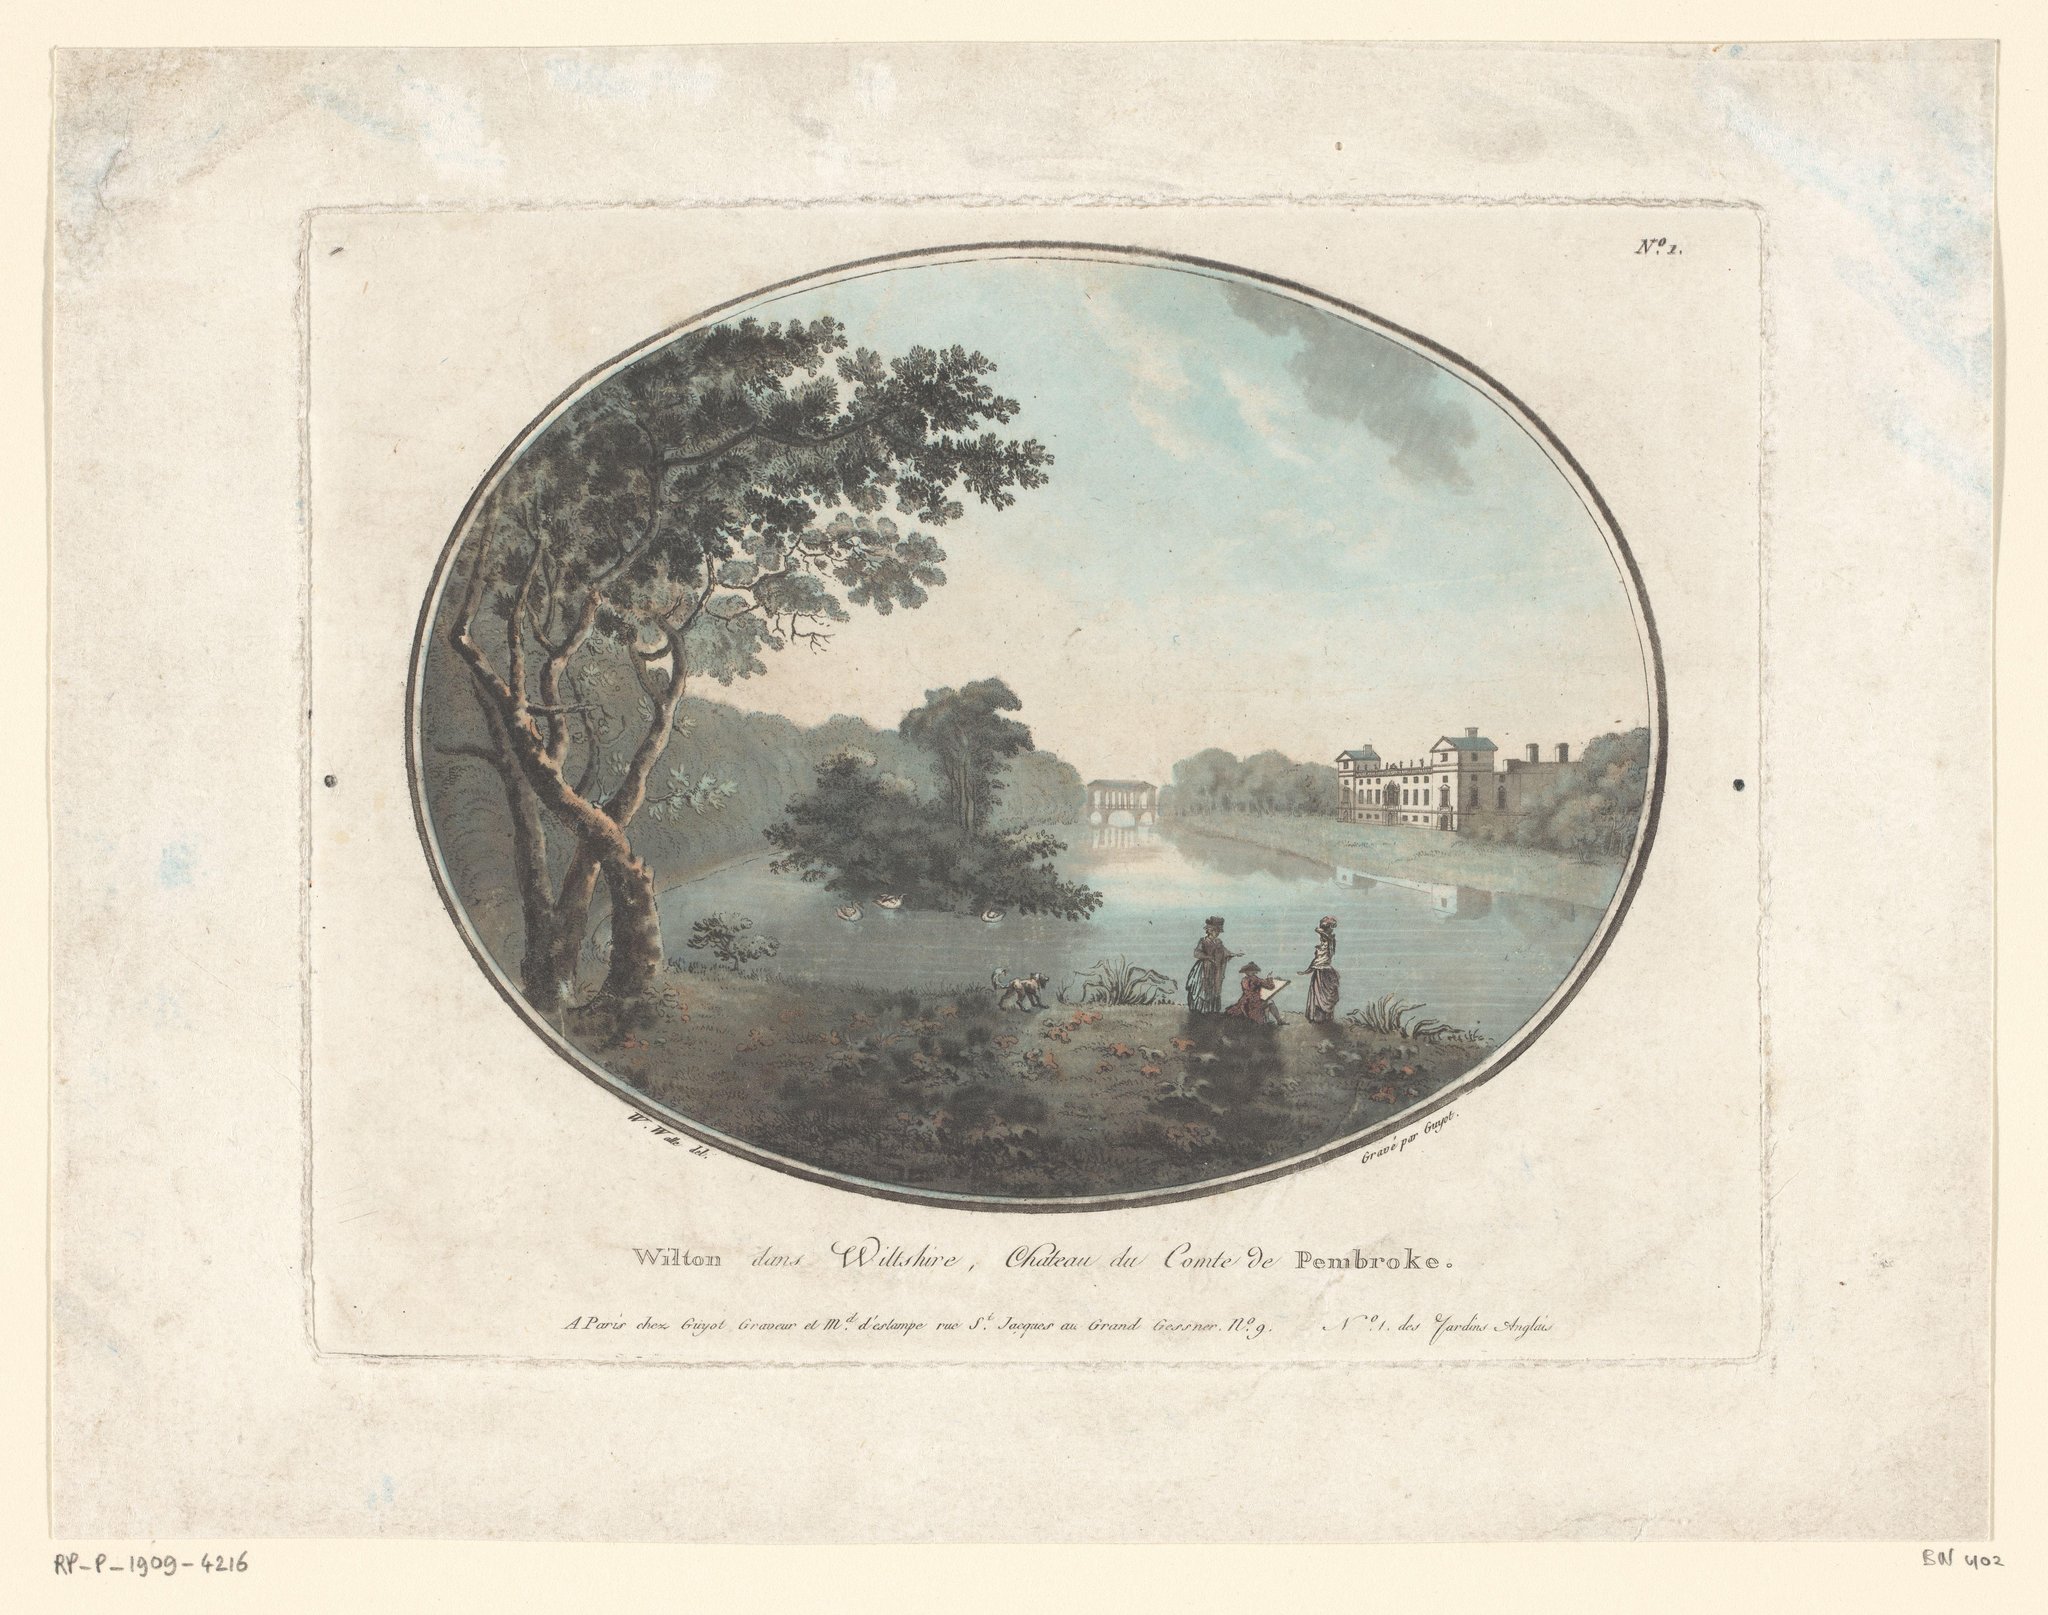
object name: print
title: Jardins Anglais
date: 1788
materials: paper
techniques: etching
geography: paris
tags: garden, country-house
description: Maakt deel uit van een twaalfdelige serie met buitenhuizen in de buurt van Londen. Vijf van de twaalf prenten door Guyot zijn bekend. Mogelijk zijn de overige platen nooit voltooid.